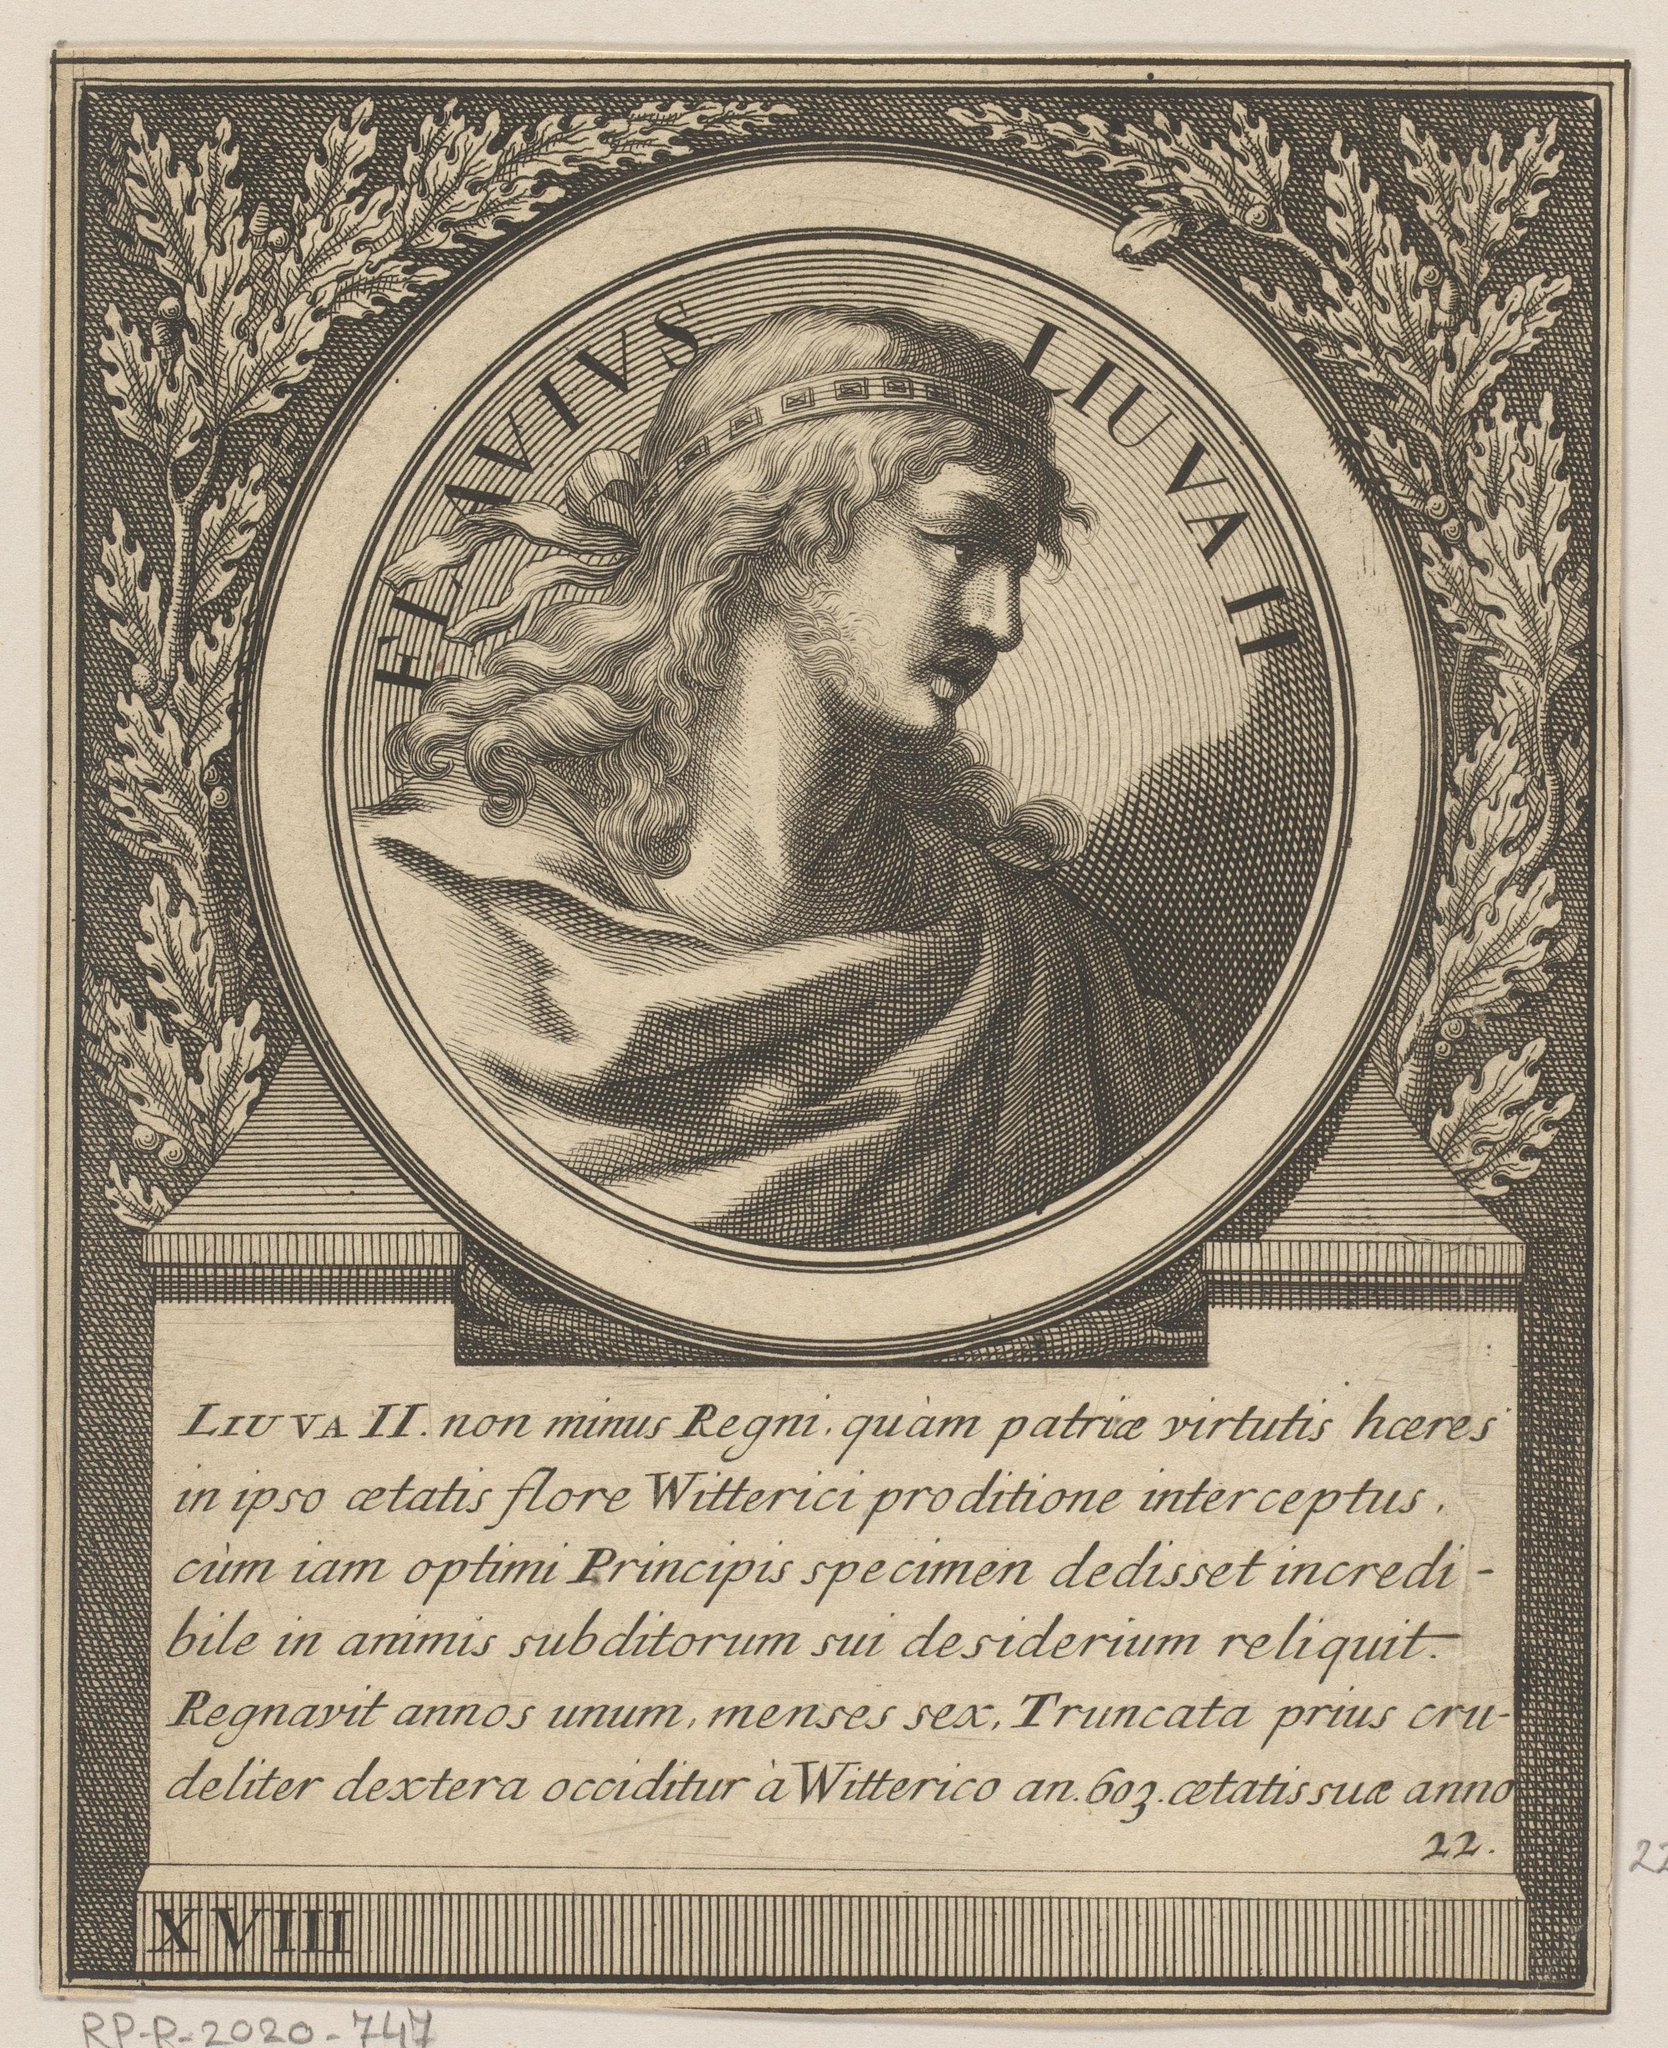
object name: print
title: Flavius Liuva II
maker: Anonymous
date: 1650-1699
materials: paper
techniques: engraving, etching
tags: historical persons, ruler, sovereign